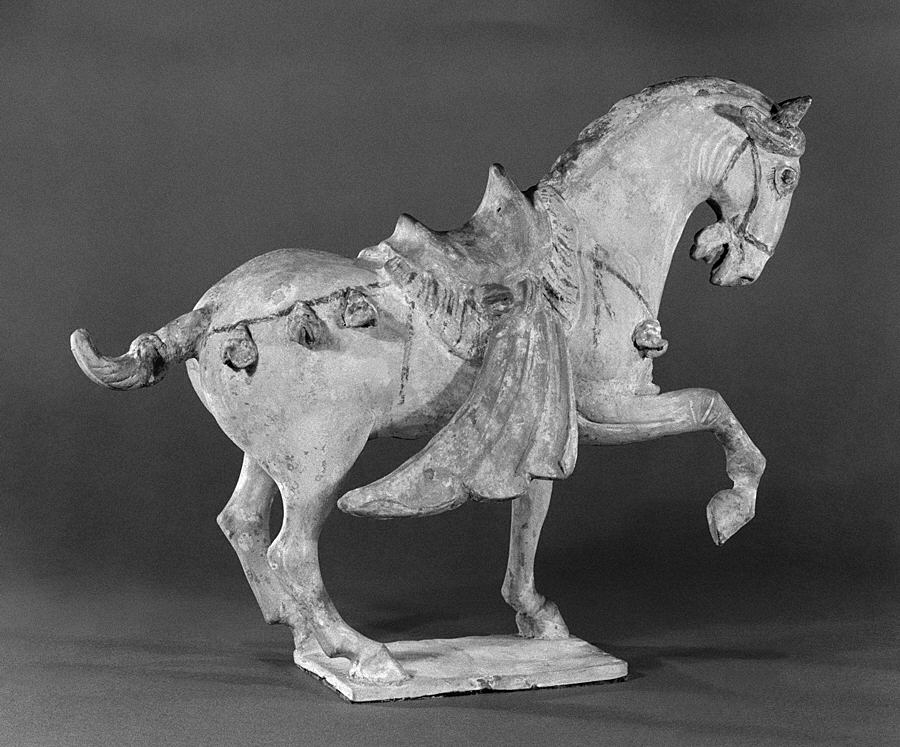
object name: figure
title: Horse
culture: chinese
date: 601-800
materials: earthenware, pigment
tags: horses